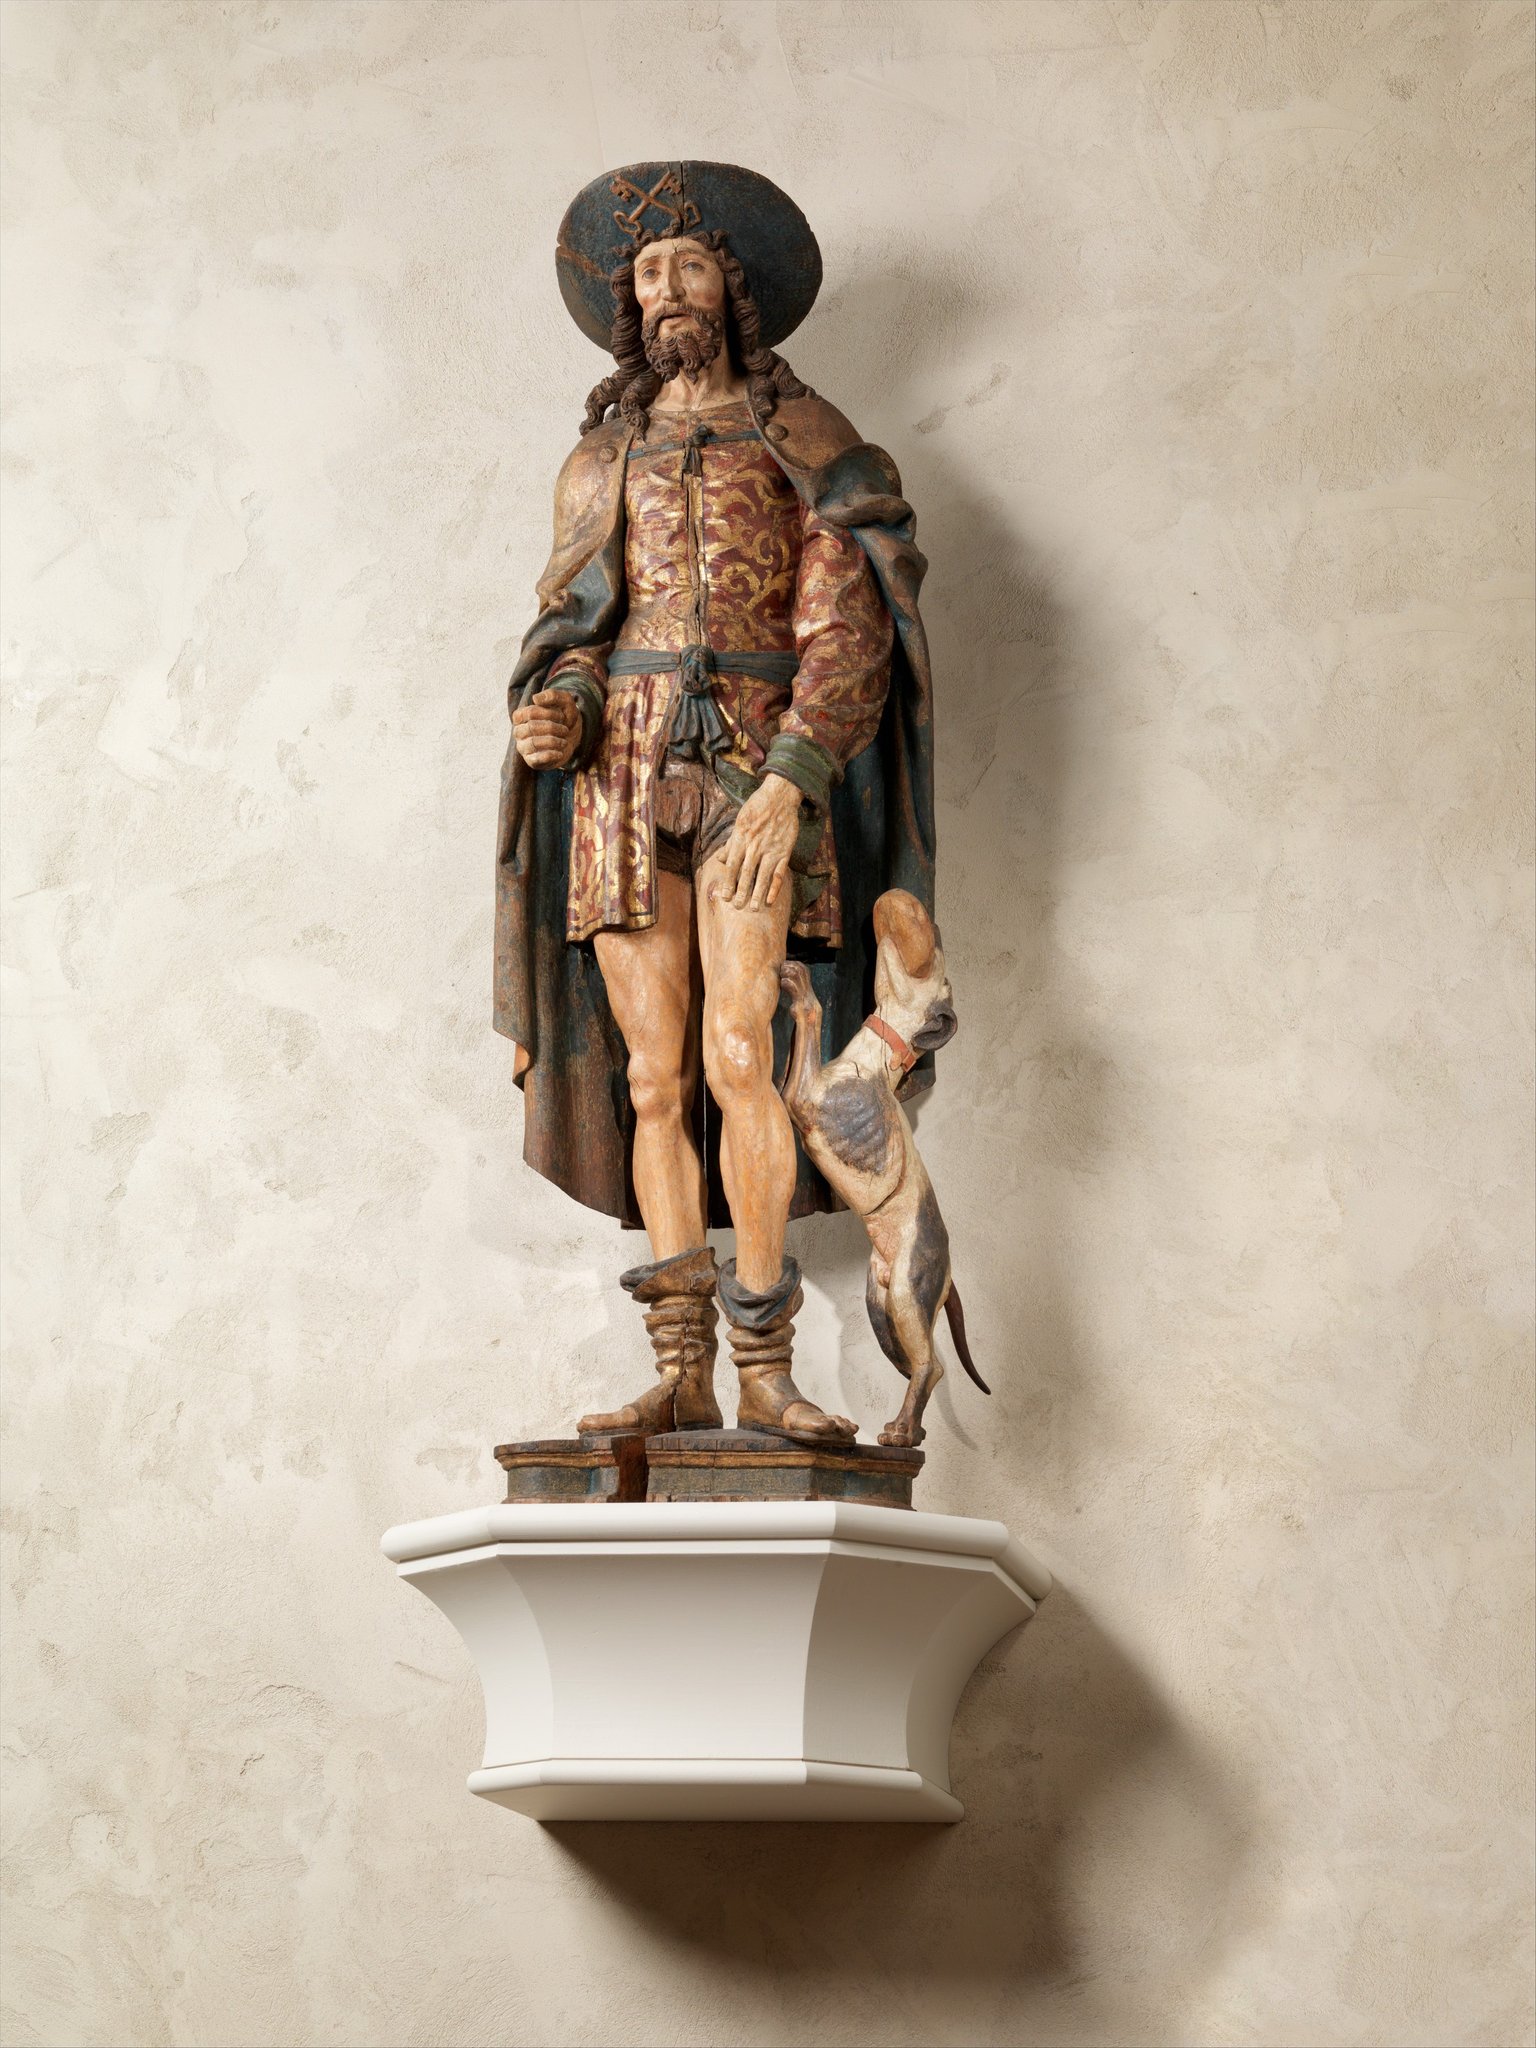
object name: statuette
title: Saint Roch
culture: french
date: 1501-1533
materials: wood, paint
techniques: gilding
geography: france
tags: men,dogs,saints